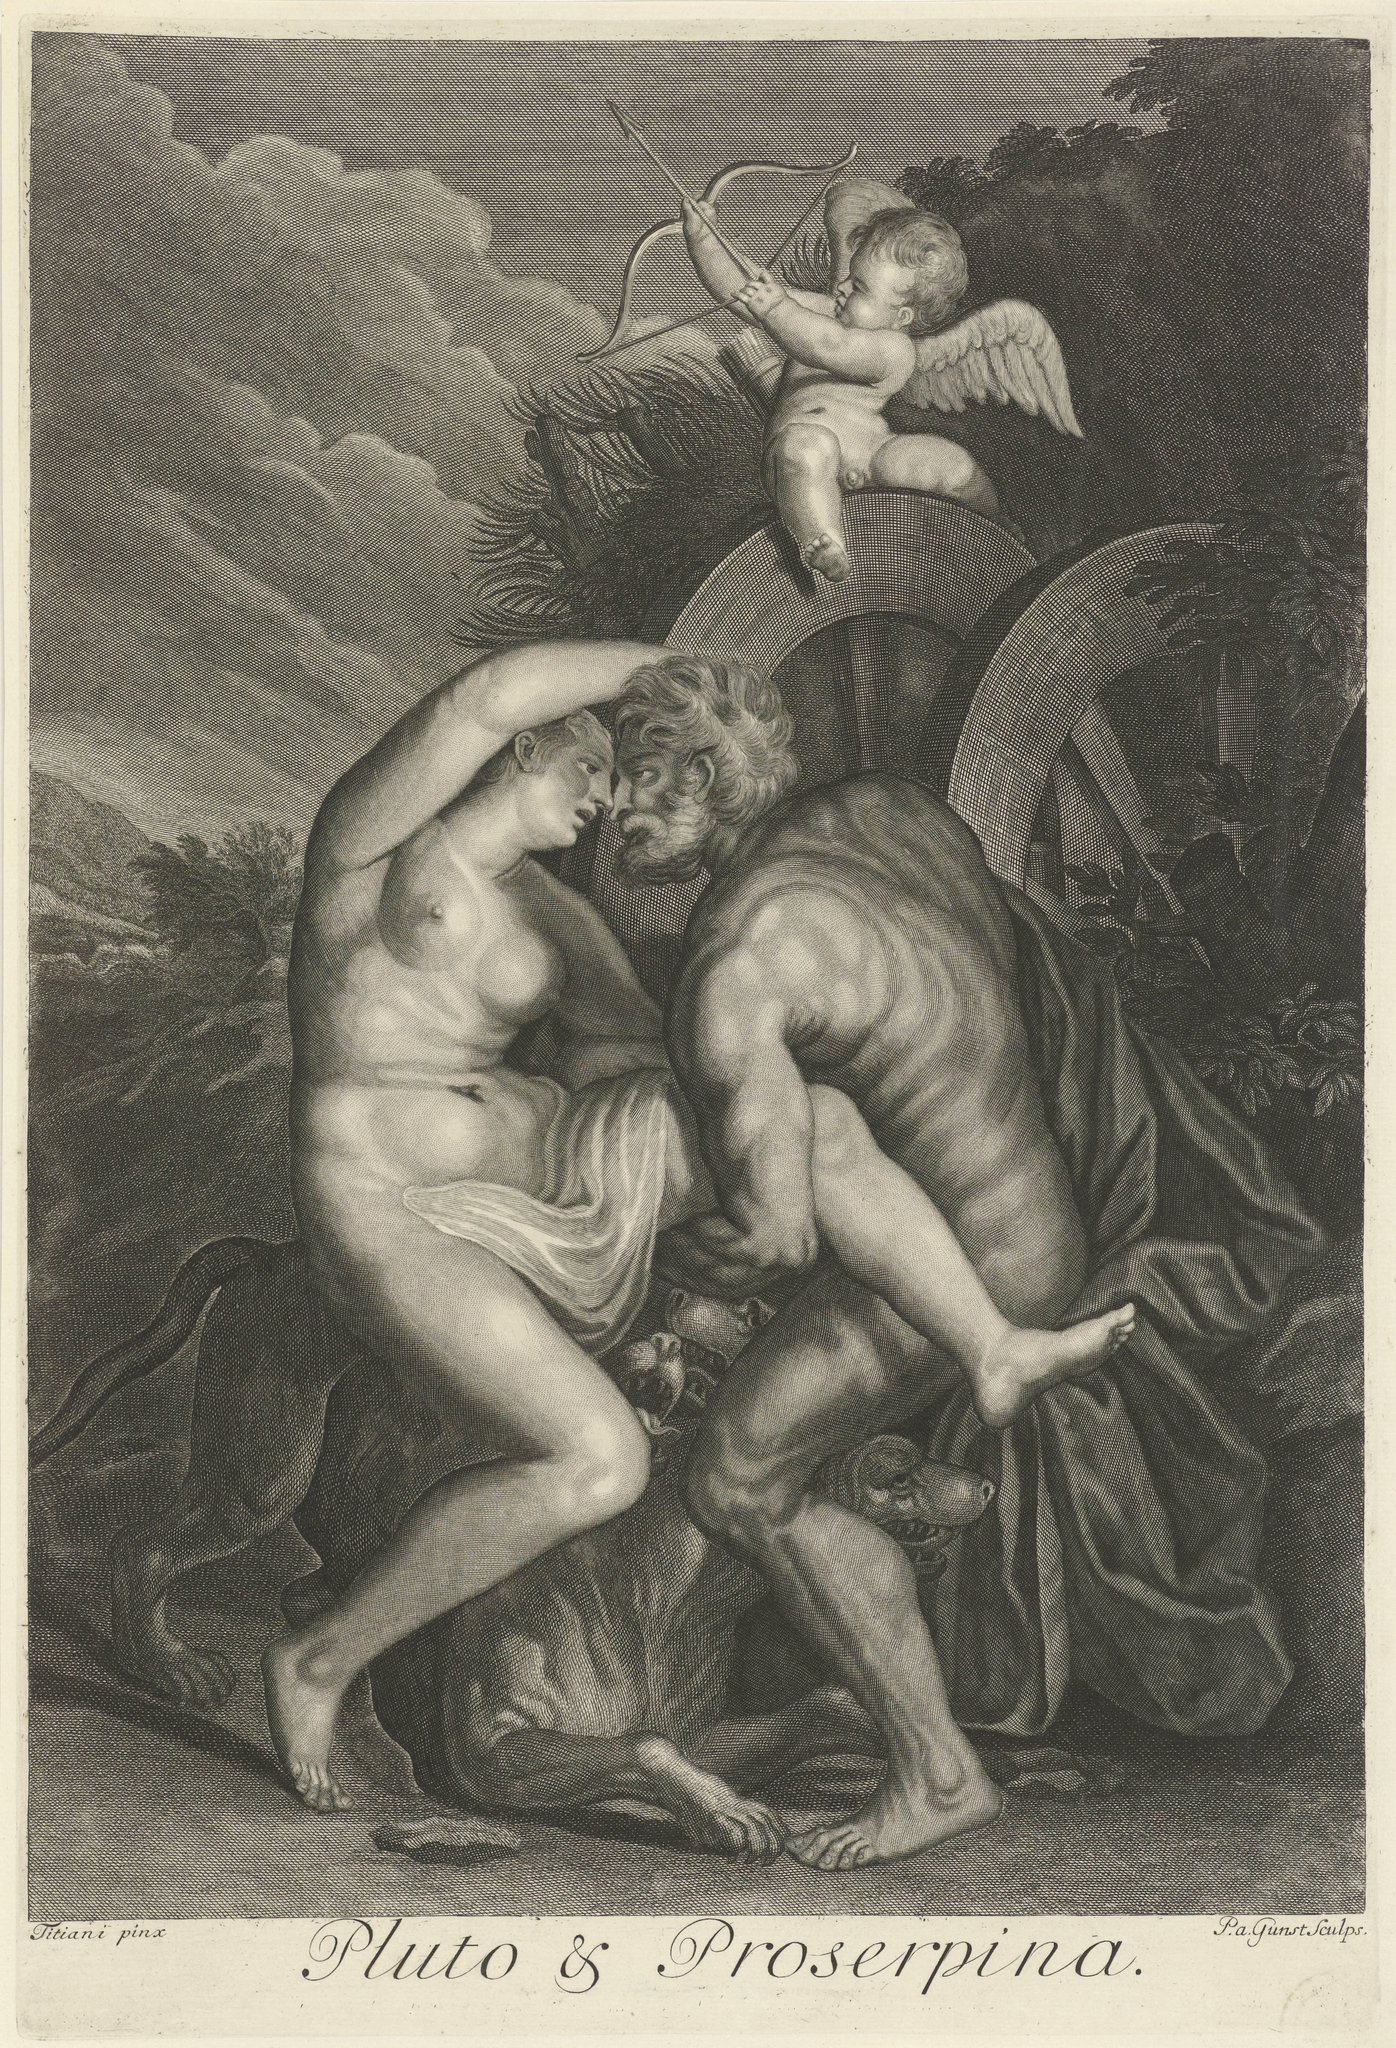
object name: print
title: Roof van Proserpina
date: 1659-1731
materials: paper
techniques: engraving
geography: amsterdam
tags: the rape of proserpina (by pluto in his chariot); possibly with diana and minerva trying to rescue her, cerberus, the three- or many-headed dog; 'cerbero' (ripa), (story of) cupid, amor (eros)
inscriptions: collector's mark: Lugt 240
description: Pluto ontvoert Proserpina, de dochter van Ceres, met behulp van de hellehond Cerberus. Op de wagen van Pluto zit Cupido.